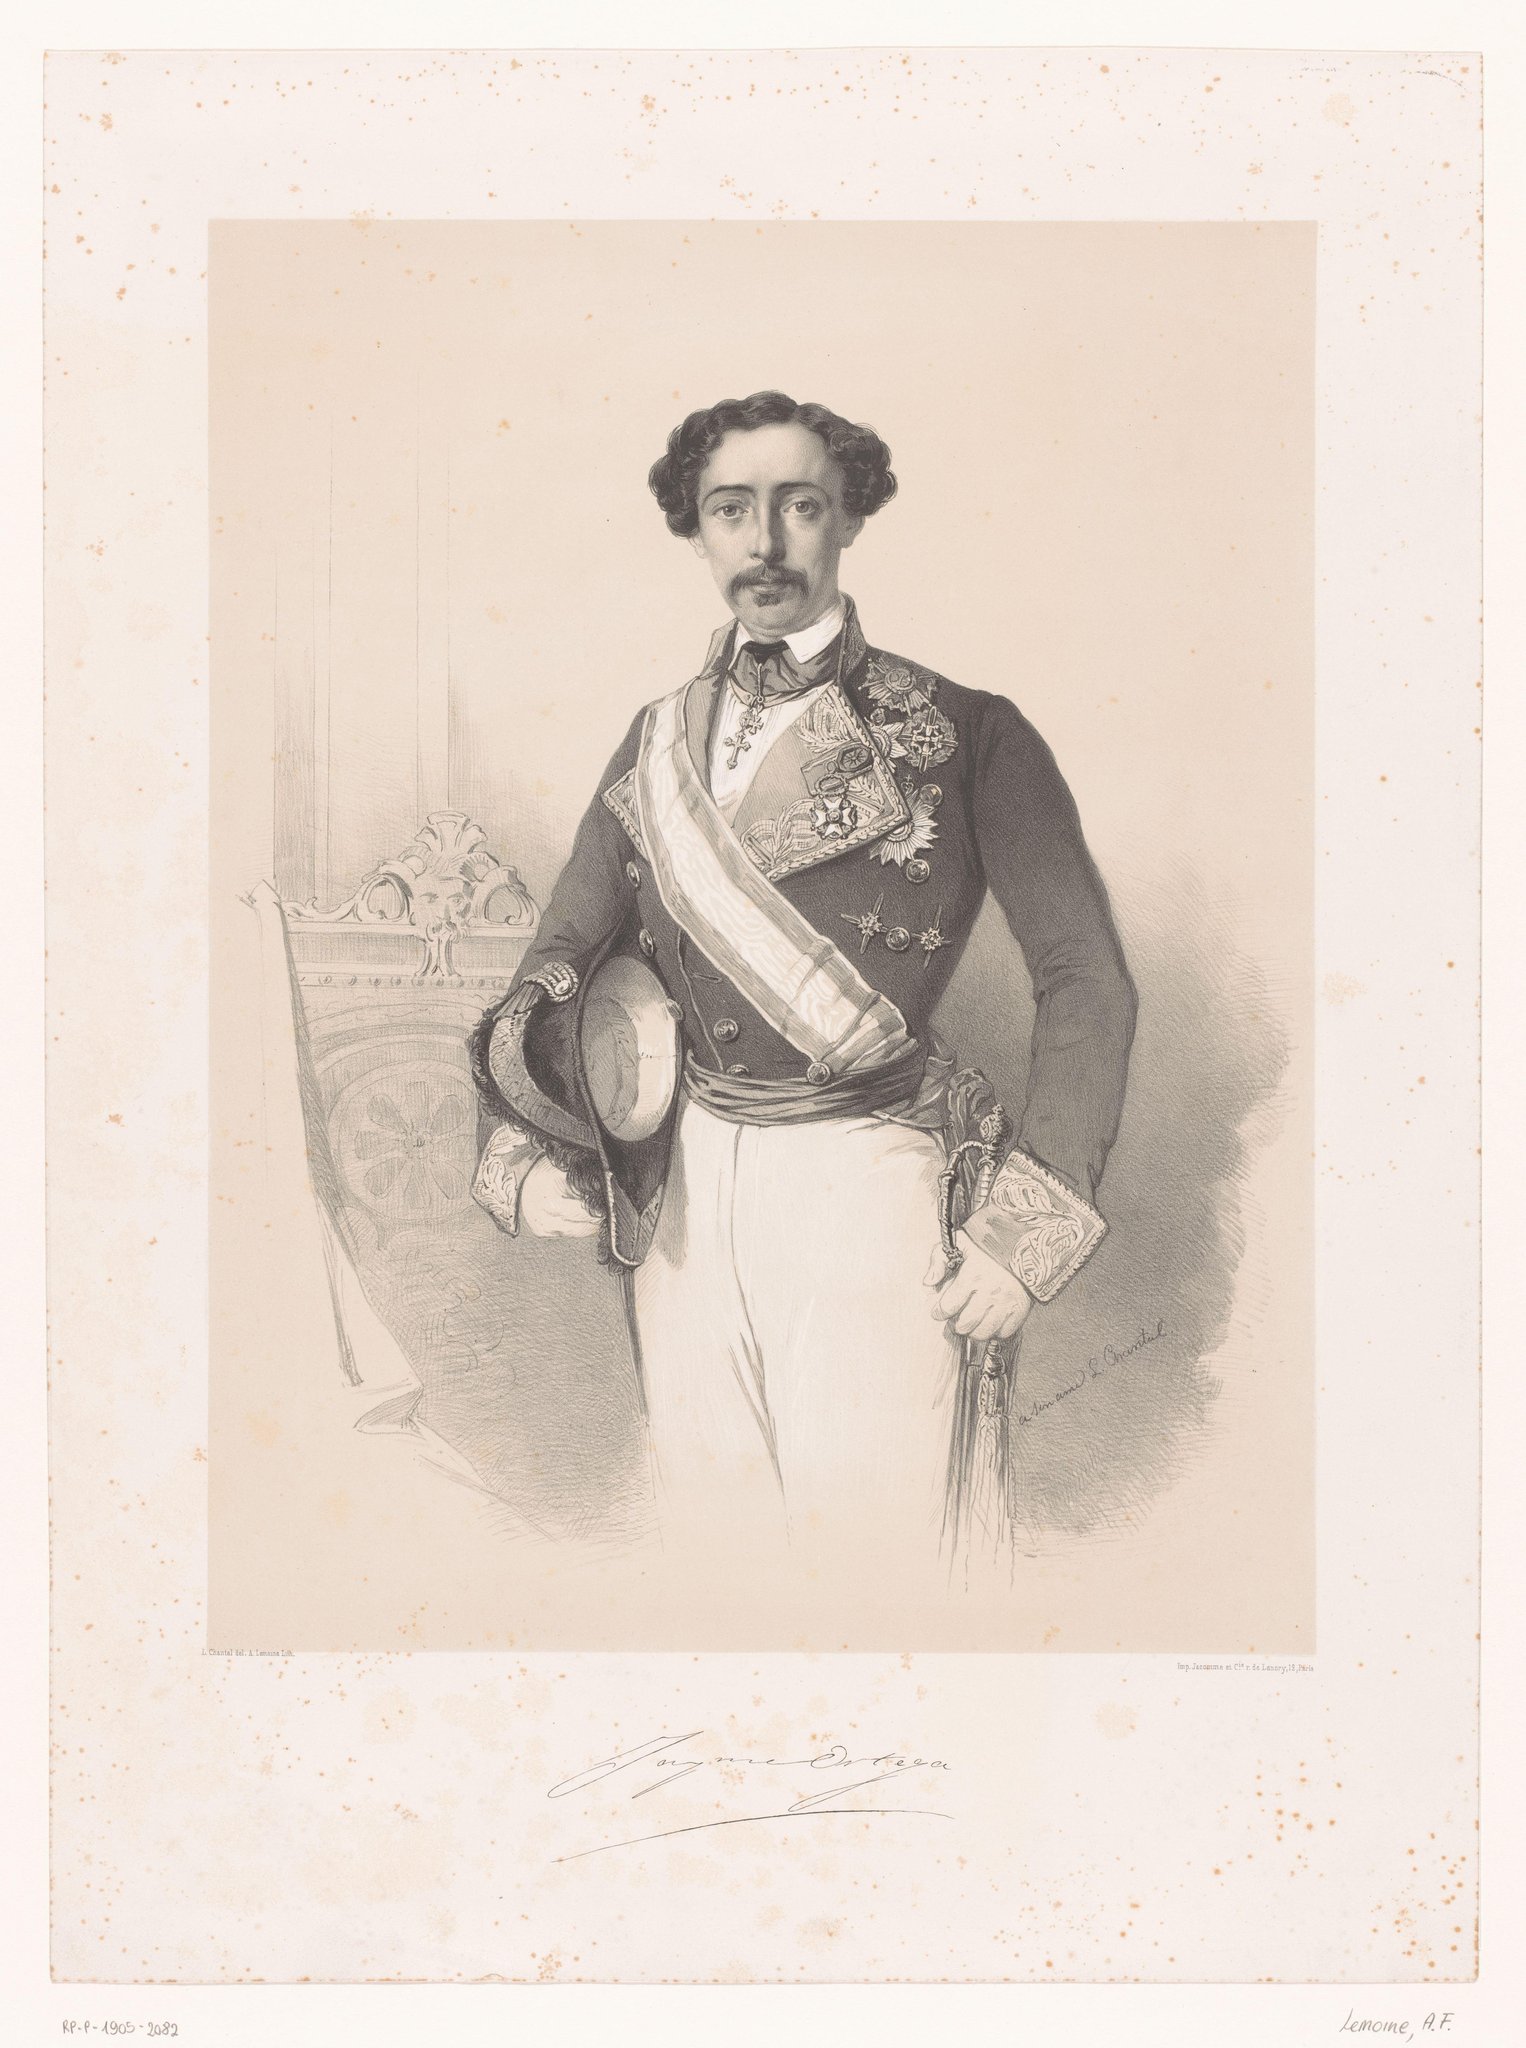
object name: print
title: Portret van J. Ortega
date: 1838-1857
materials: paper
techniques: tone lithography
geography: paris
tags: historical persons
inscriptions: collector's mark: Lugt 2228a